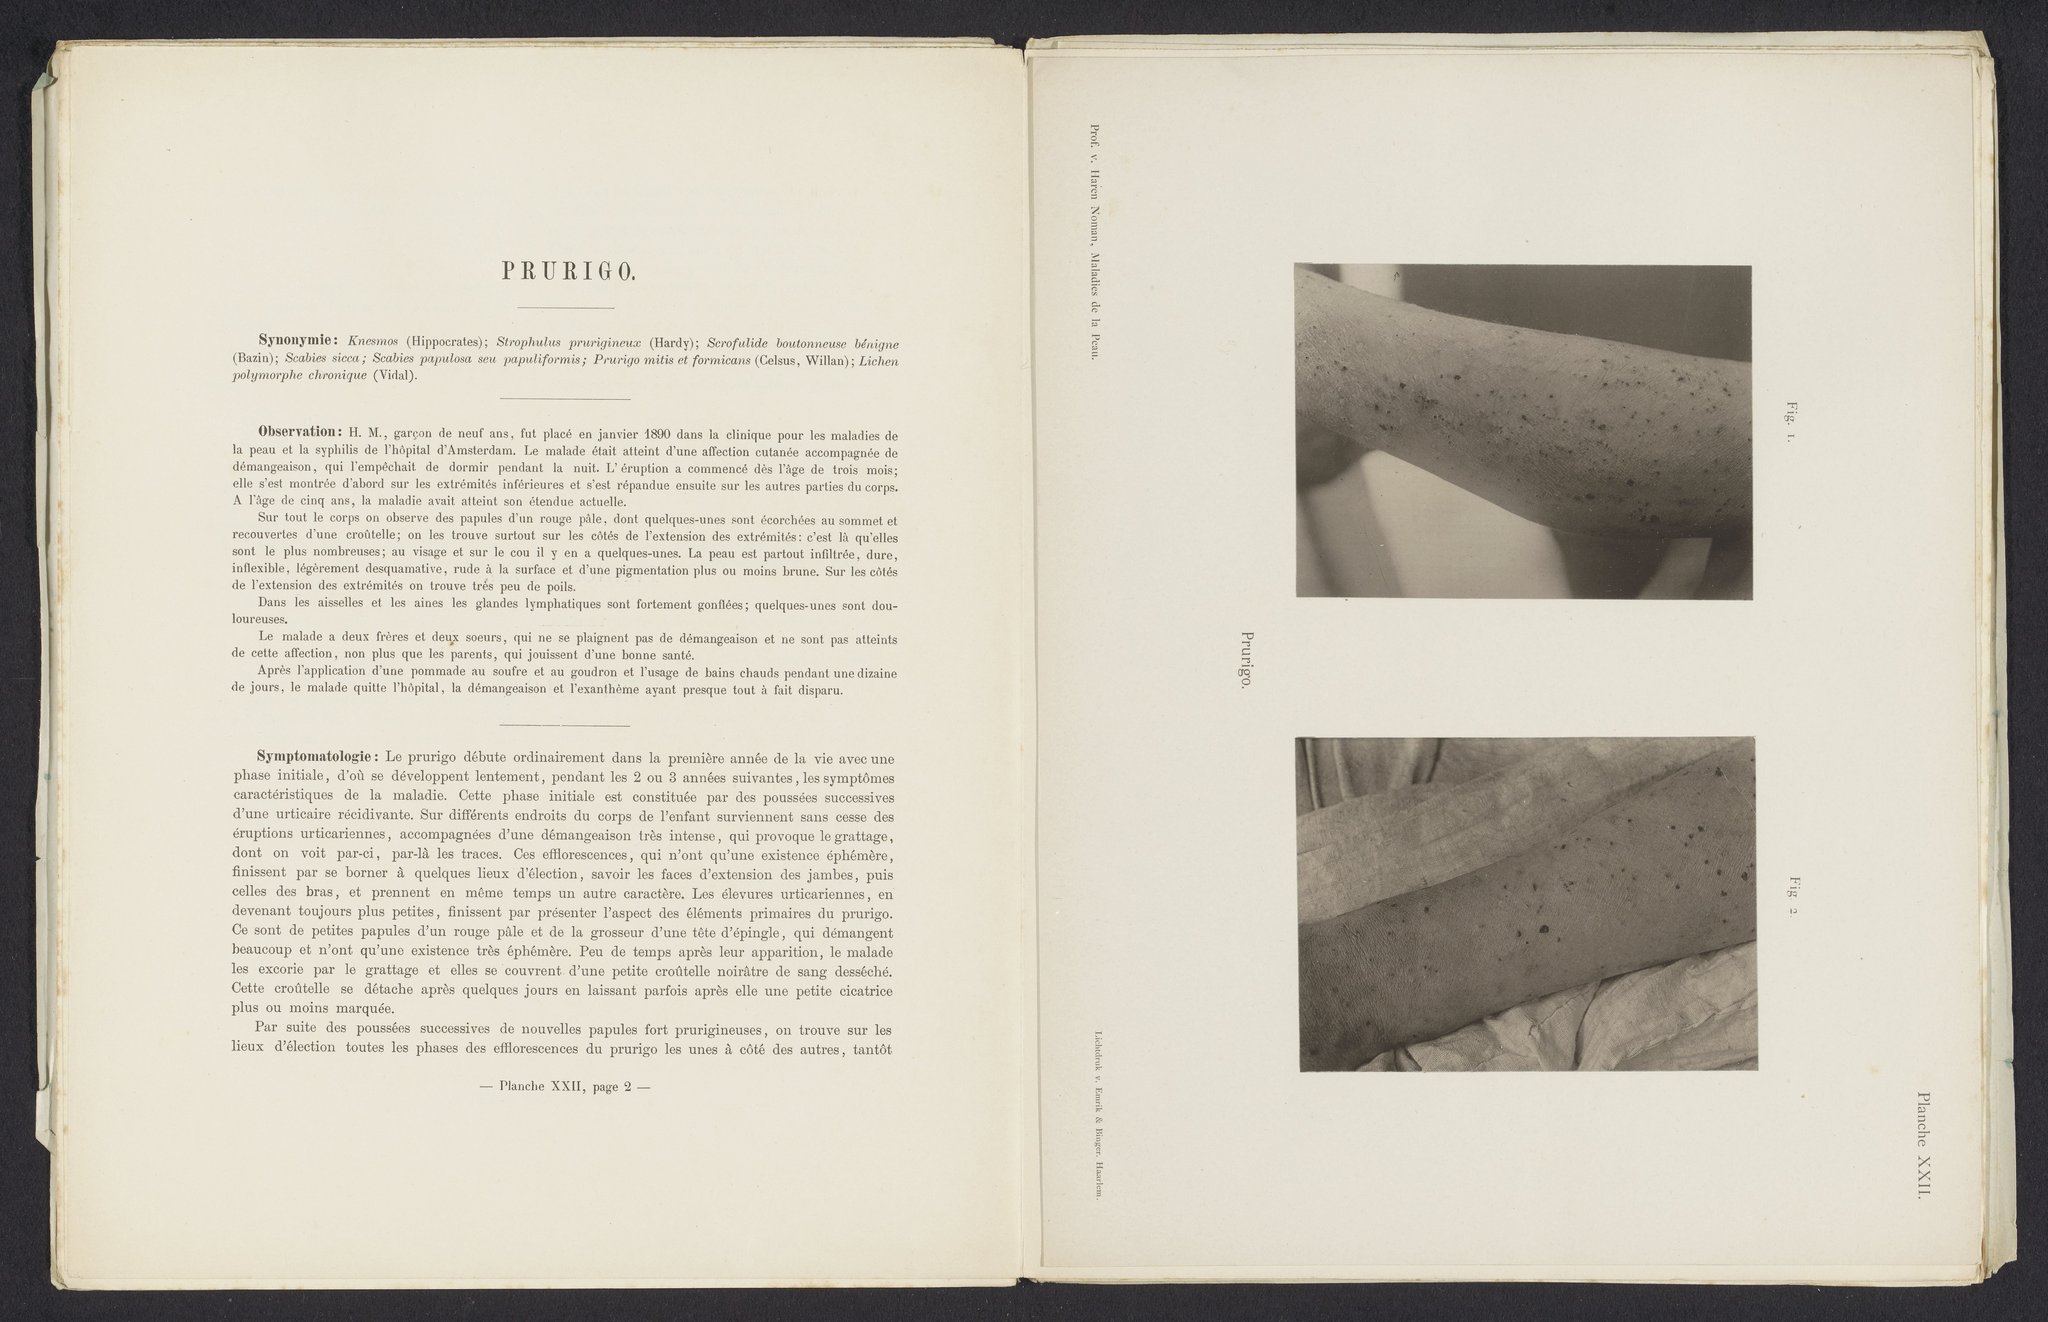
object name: photomechanical print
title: Prurigo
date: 1882-1892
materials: paper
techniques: photograph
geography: haarlem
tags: skin and venereal diseases, arms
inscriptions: number: ‘Planche XXII. / Fig. 1. / Fig. 2.’